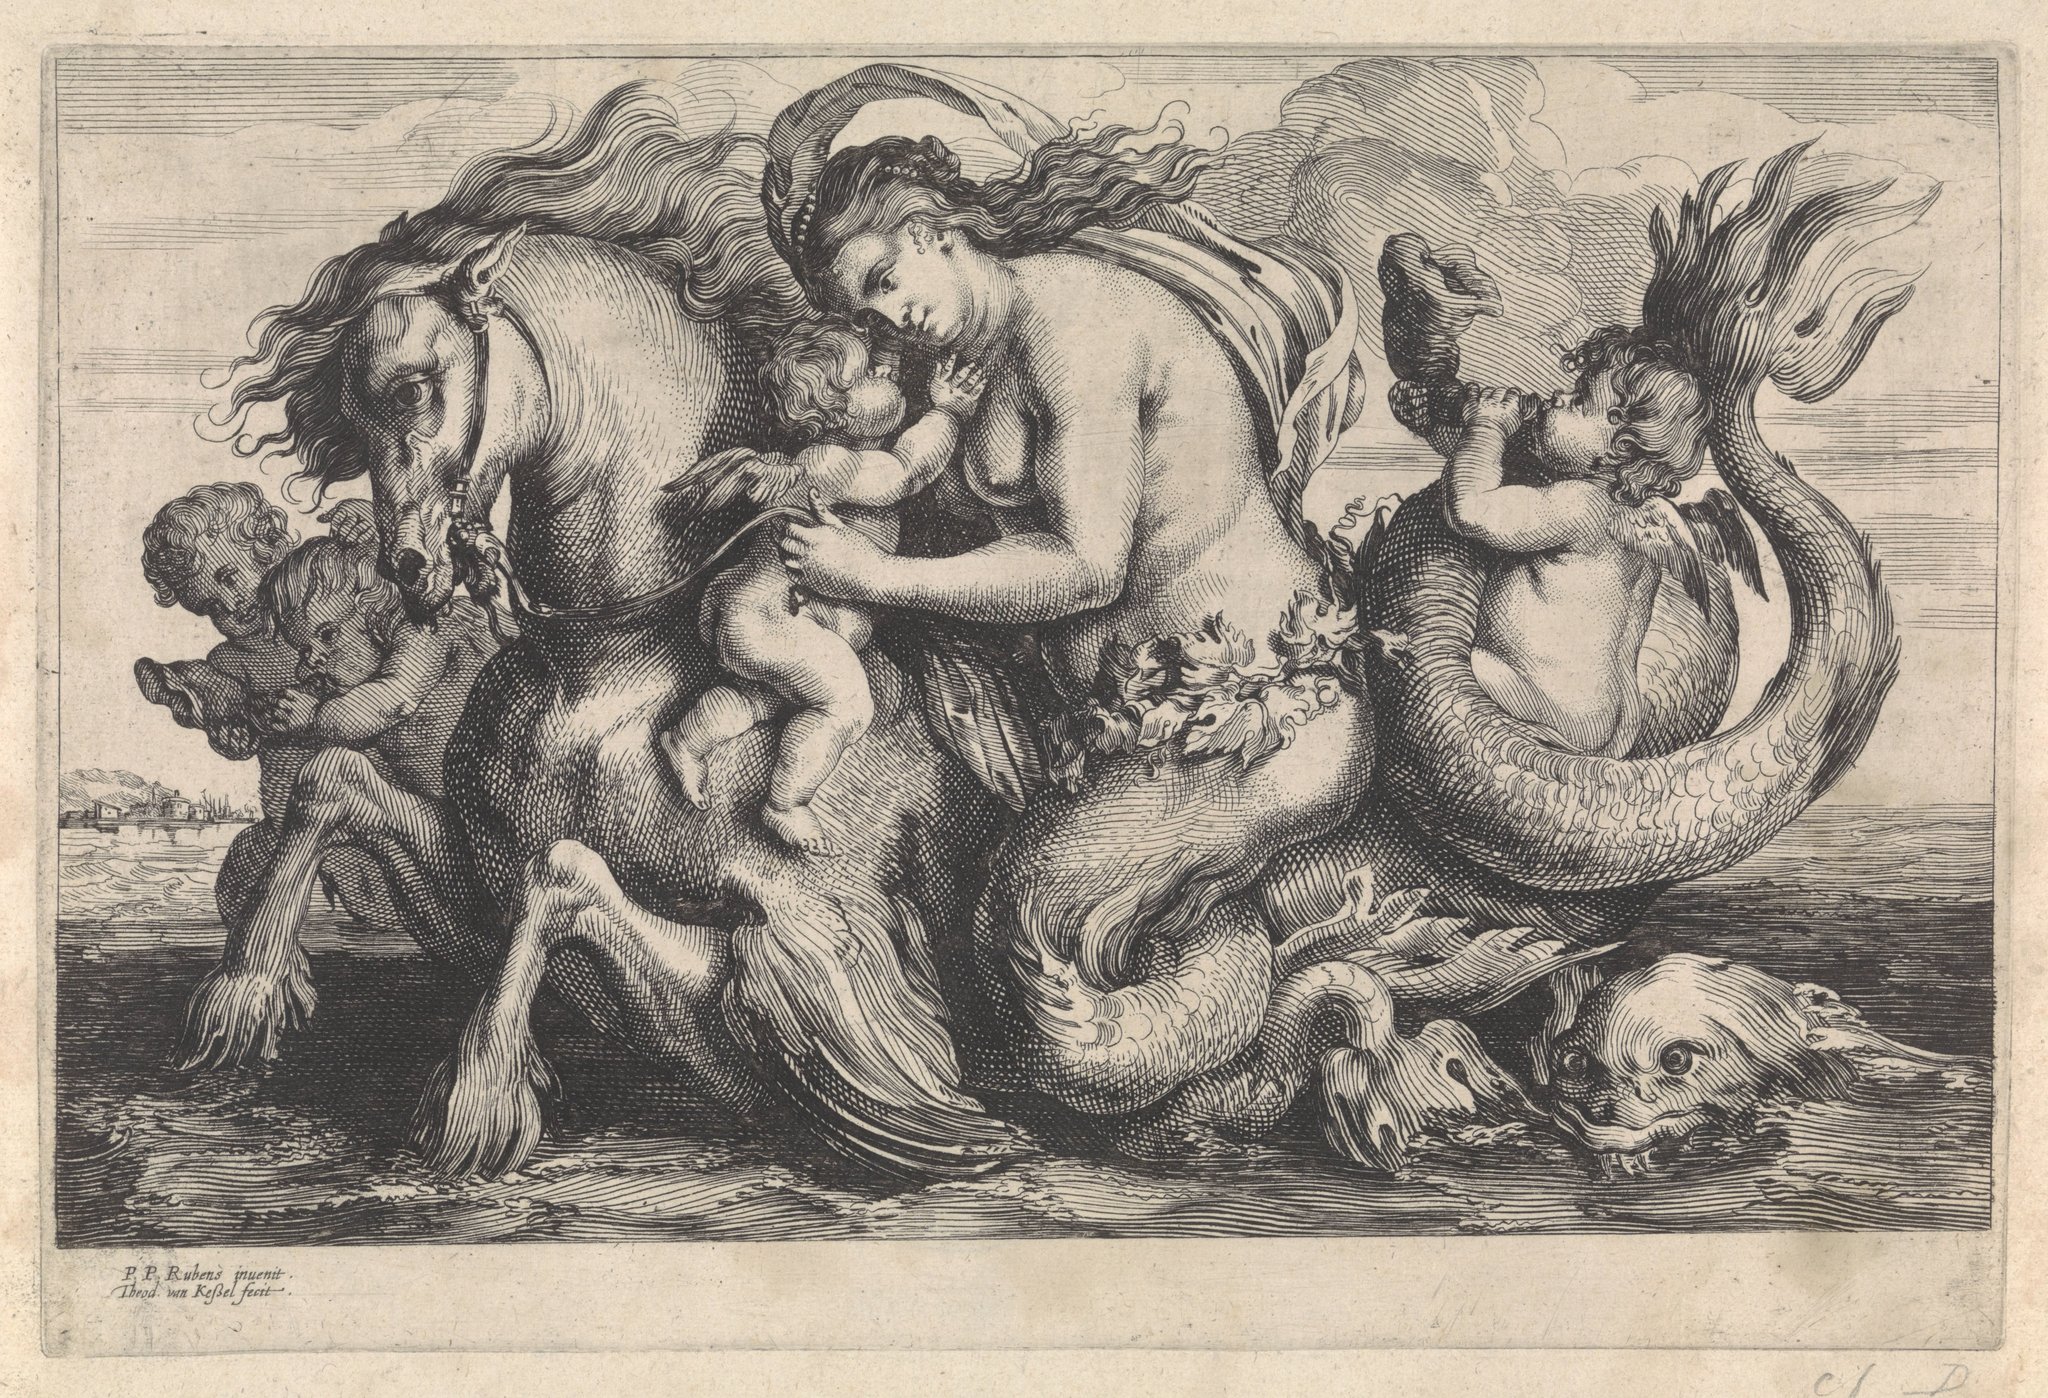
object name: print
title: Mythologische figuren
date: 1630-1660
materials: paper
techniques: engraving, etching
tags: cupids: 'amores', 'amoretti', 'putti' (+ triumph), sea-horse, hippocamp, 'hippocampus', (horse/fish) (mythological hybrid monster), triumph of galatea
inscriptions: collector's mark: Lugt 2228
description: De triomf van de zeegodin Galatea. De naakte Galatea wordt door een zeepaard door het water gevoerd, terwijl ze wordt vergezeld door vier putti, waarvan twee op een schelp blazen. Deze prent maakt deel uit van een vierdelige serie over mythologische figuren.